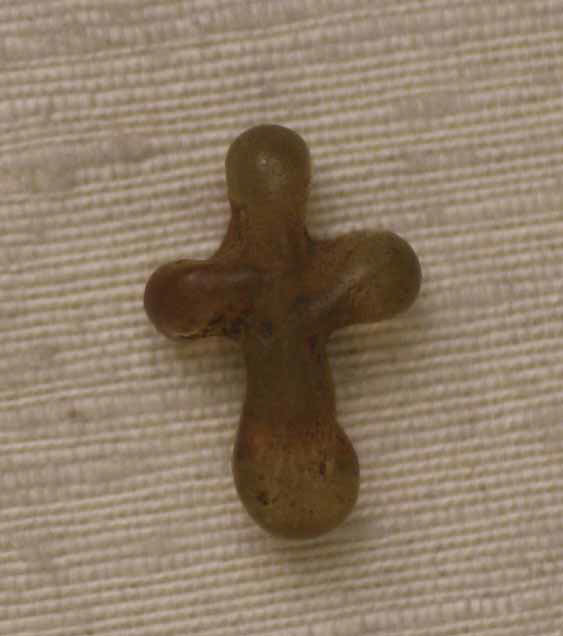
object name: cross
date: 201-1200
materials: glass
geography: egypt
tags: cross